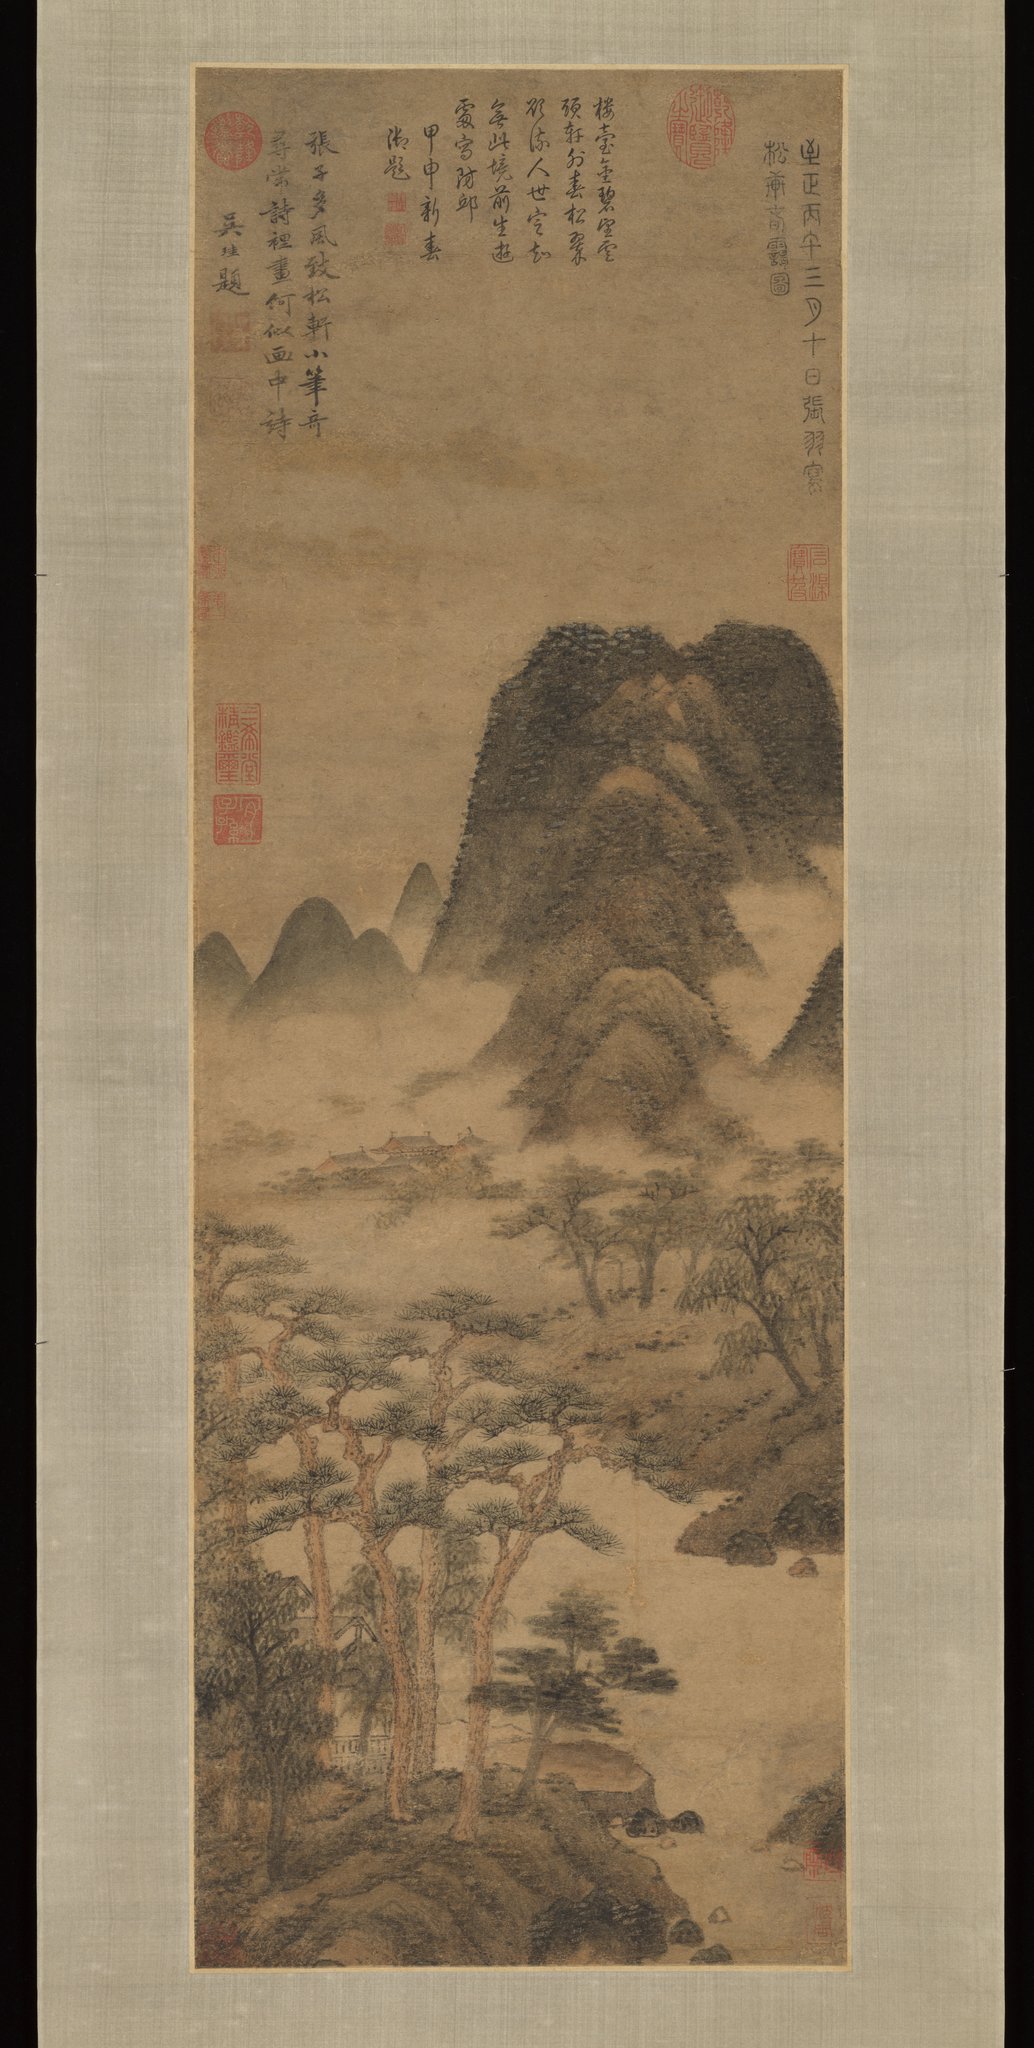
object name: hanging scroll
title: Spring Clouds at the Pine Studio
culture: chinese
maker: zhang yu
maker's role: artist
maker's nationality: chinese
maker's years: 1333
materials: ink, paper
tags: mountains,landscapes